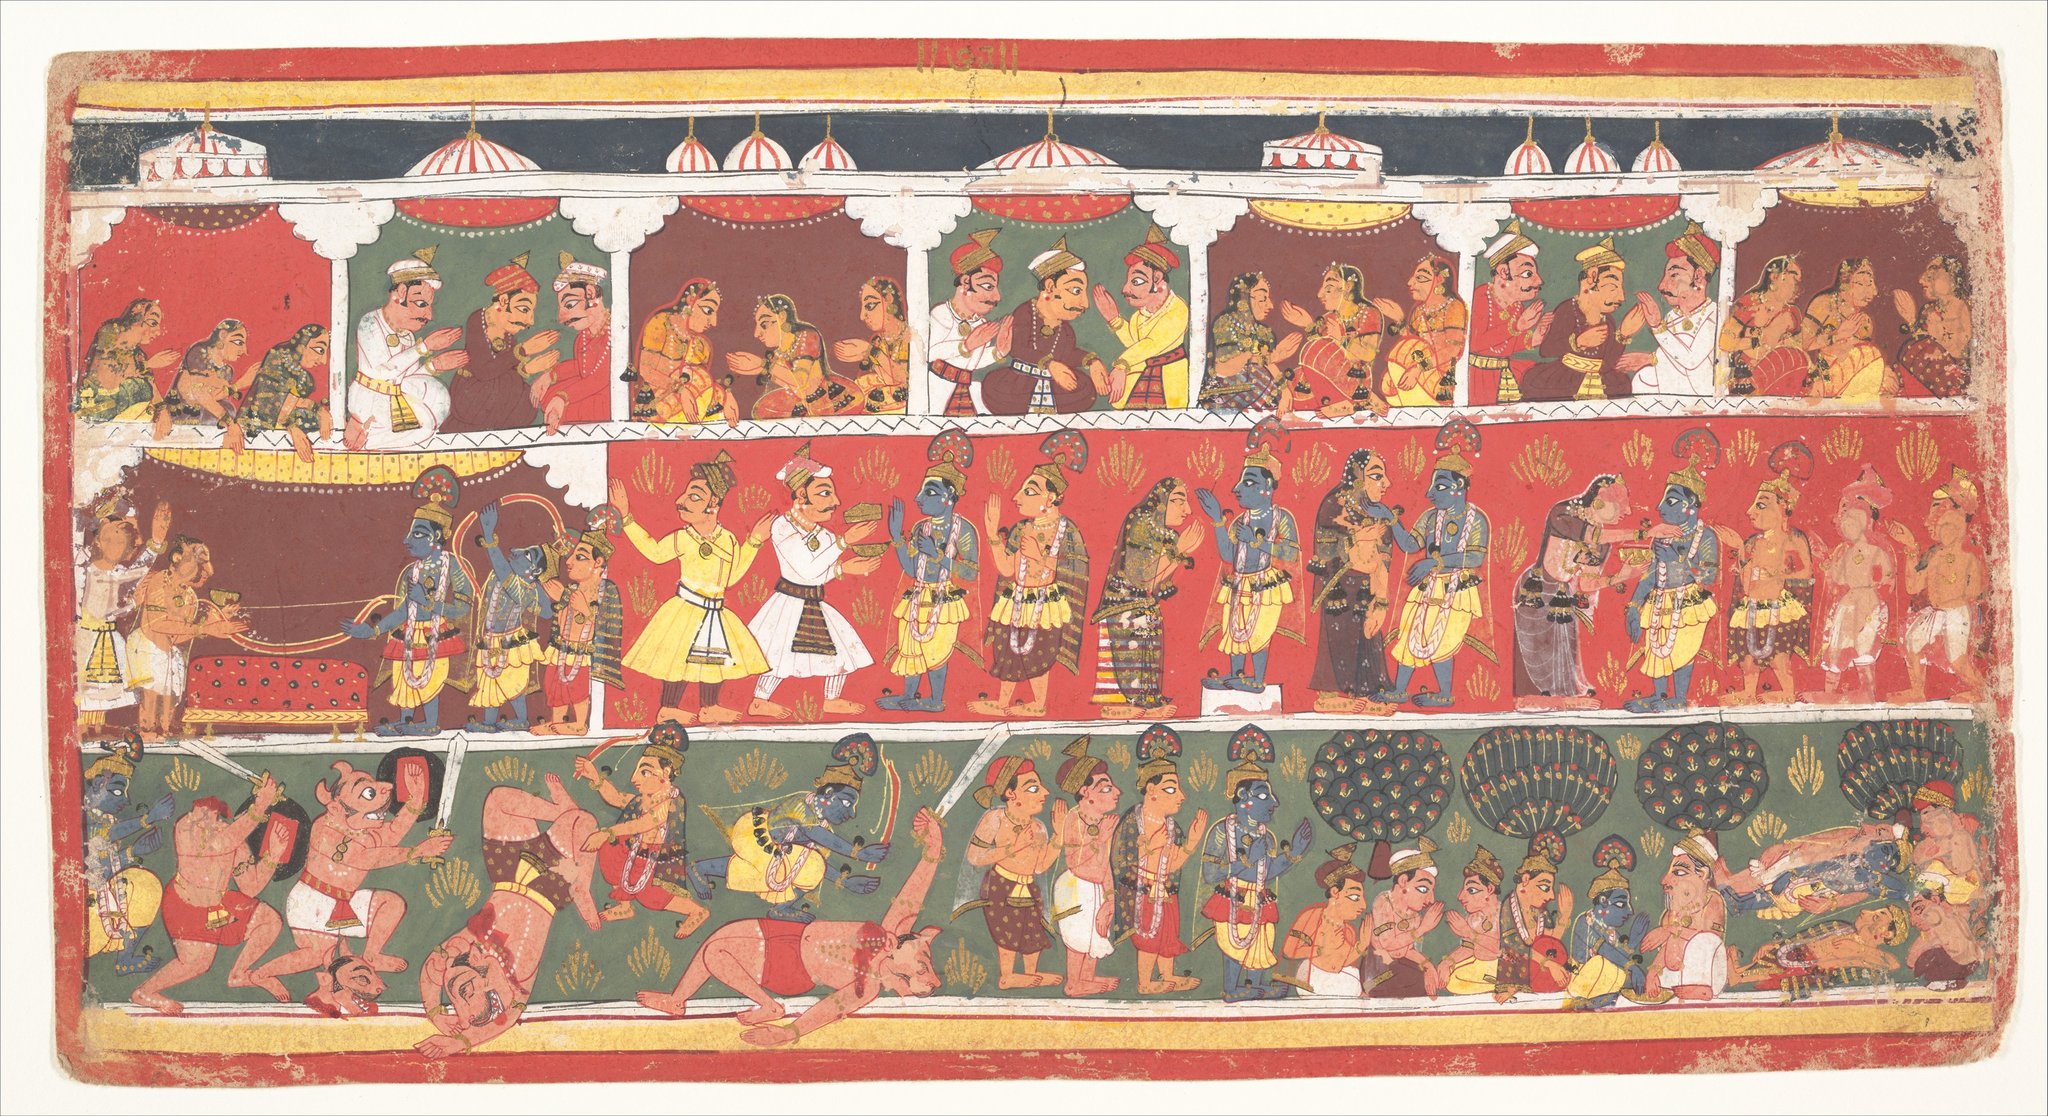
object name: folio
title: Encounters in Mathura: Page from a Dispersed Bhagavata Purana (Ancient Stories of Lord Vishnu)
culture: indian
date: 1700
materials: ink, paper, watercolor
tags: men,women,krishna